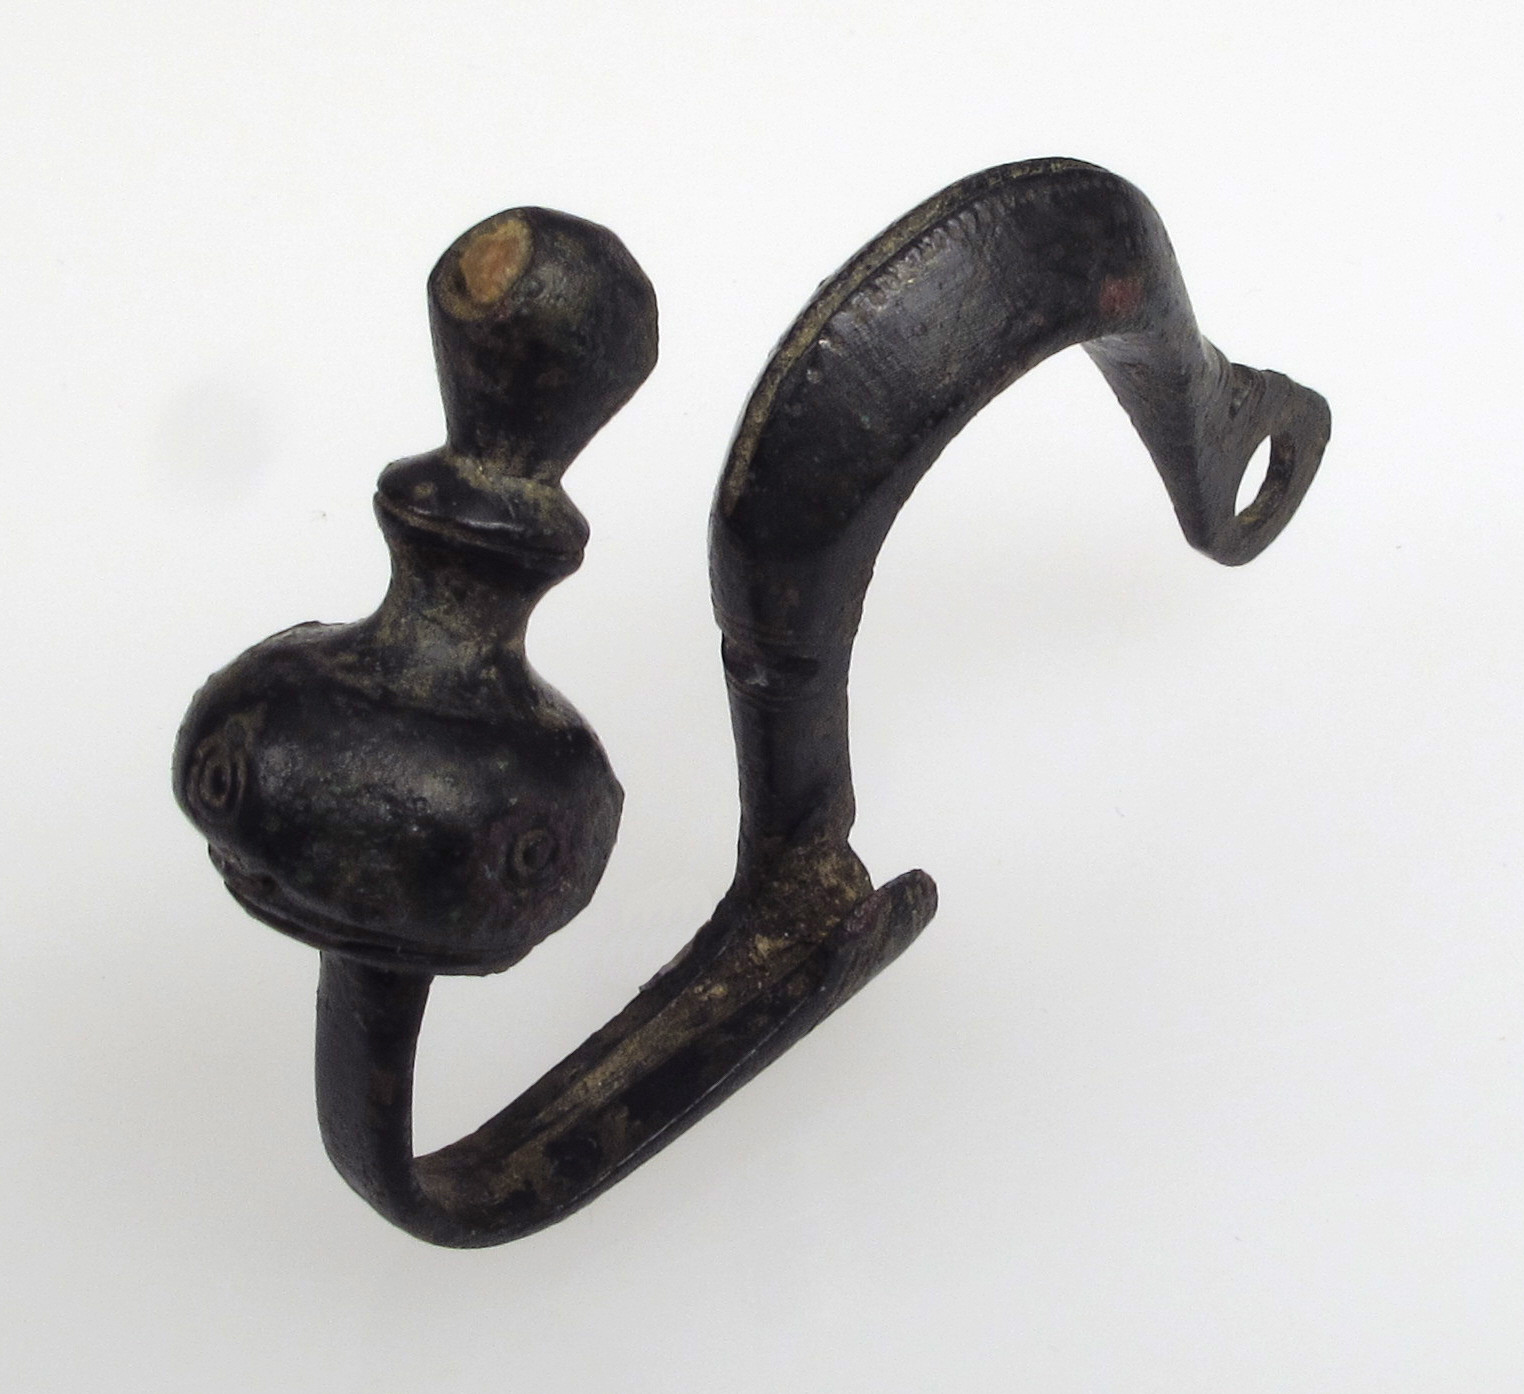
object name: brooch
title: Bow of a Brooch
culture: celtic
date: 434-401 BCE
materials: copper alloy